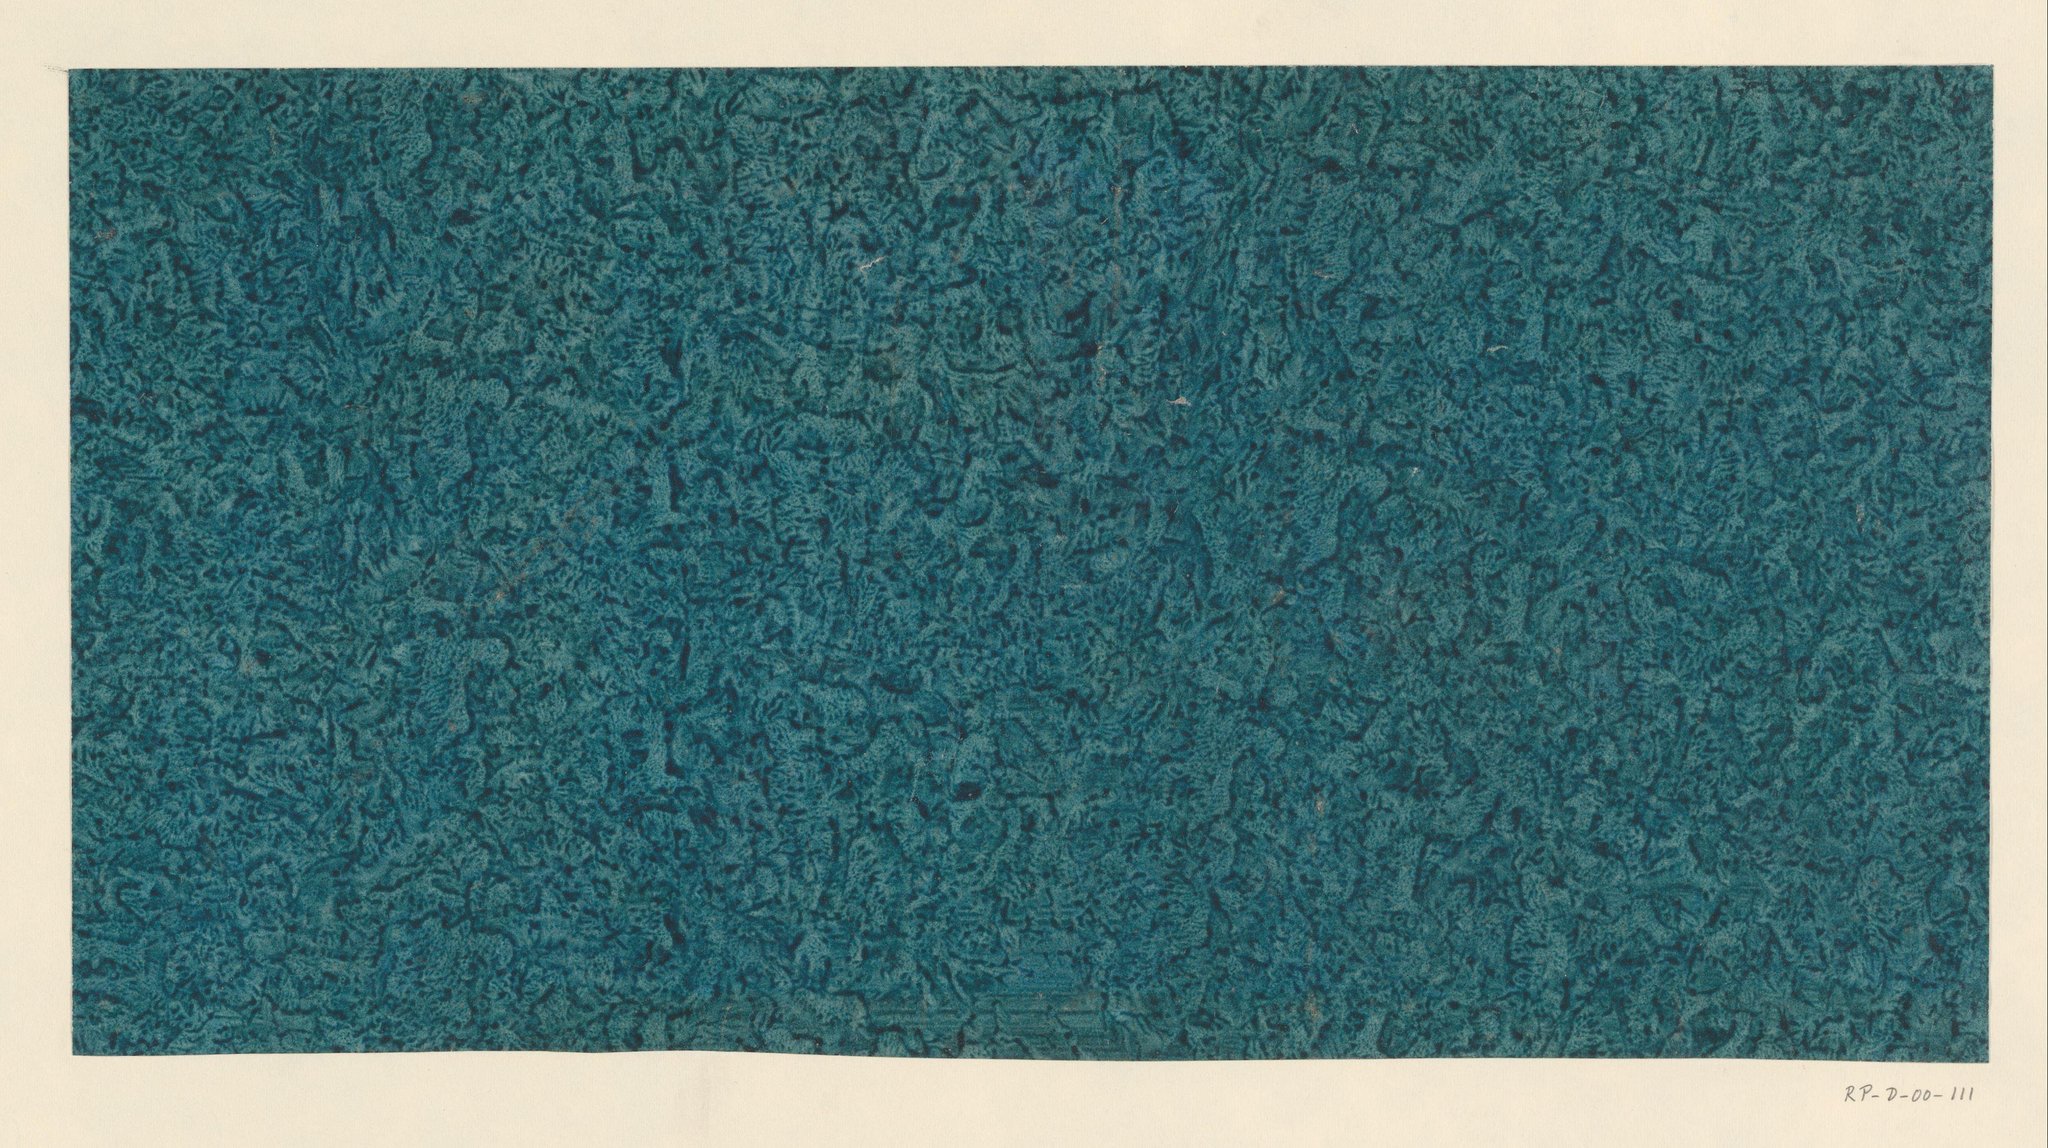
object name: paste paper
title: Geaderd stijfselverfpapier in blauw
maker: Anonymous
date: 1700-1900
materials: paper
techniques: starch dyeing